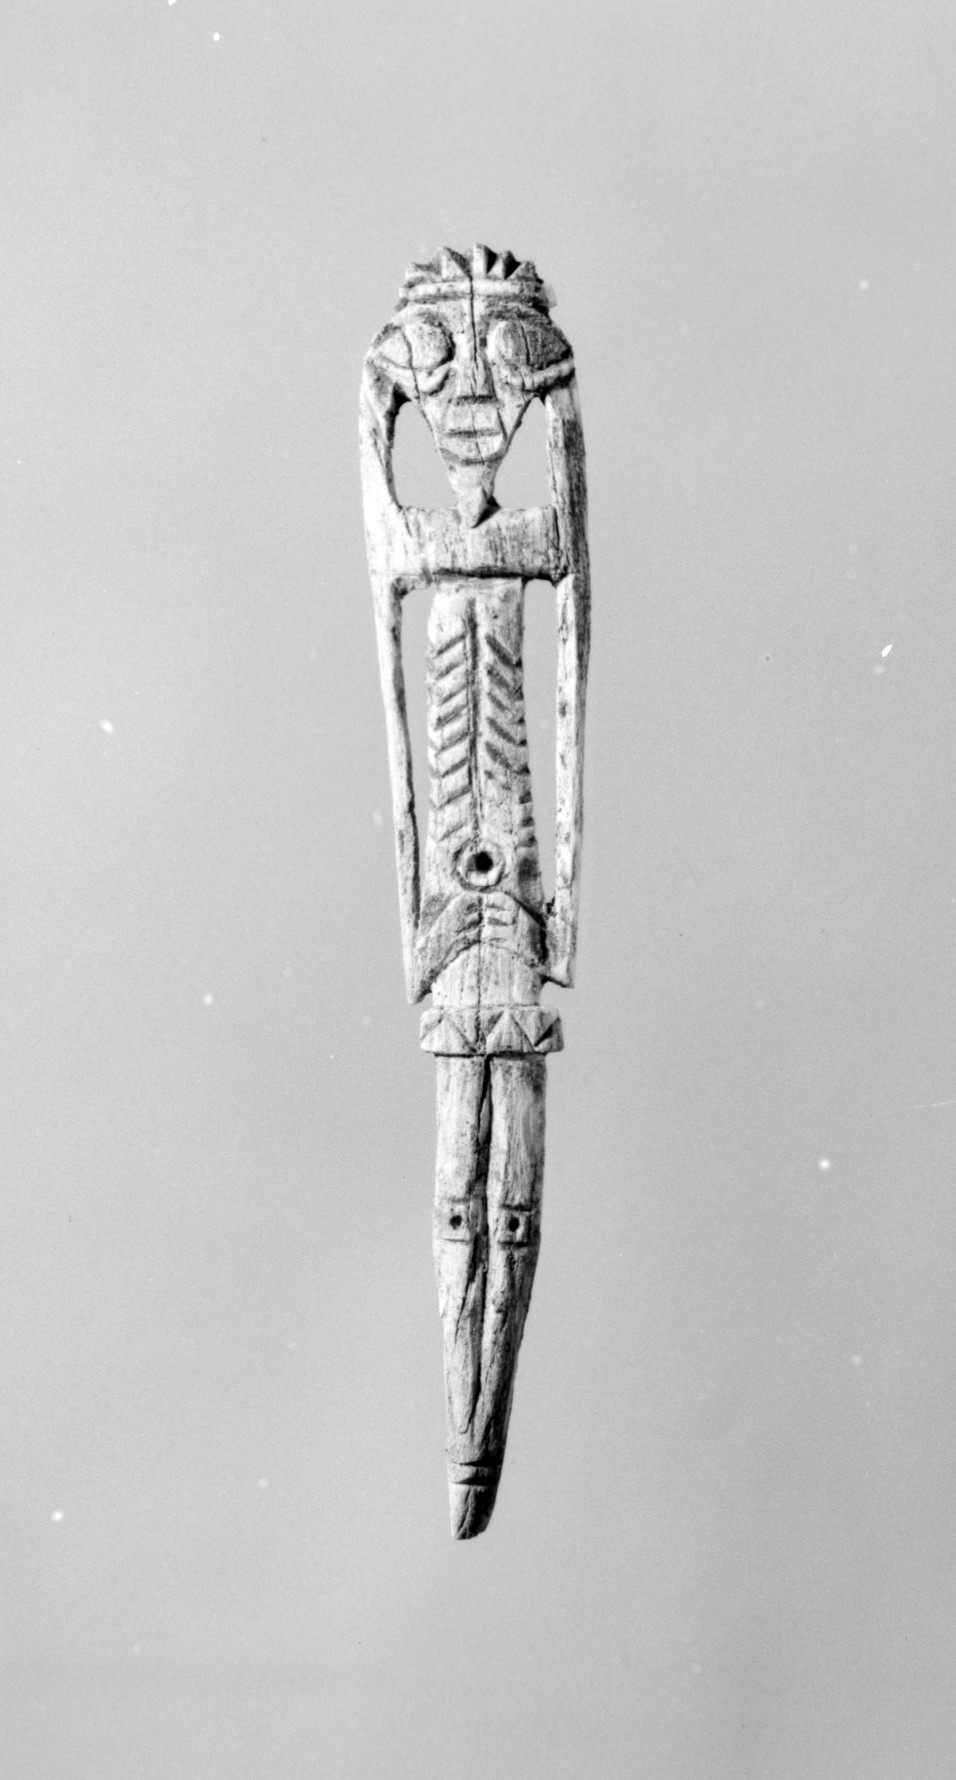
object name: figure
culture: columbia river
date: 1701-1800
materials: bone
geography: united states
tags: human figures